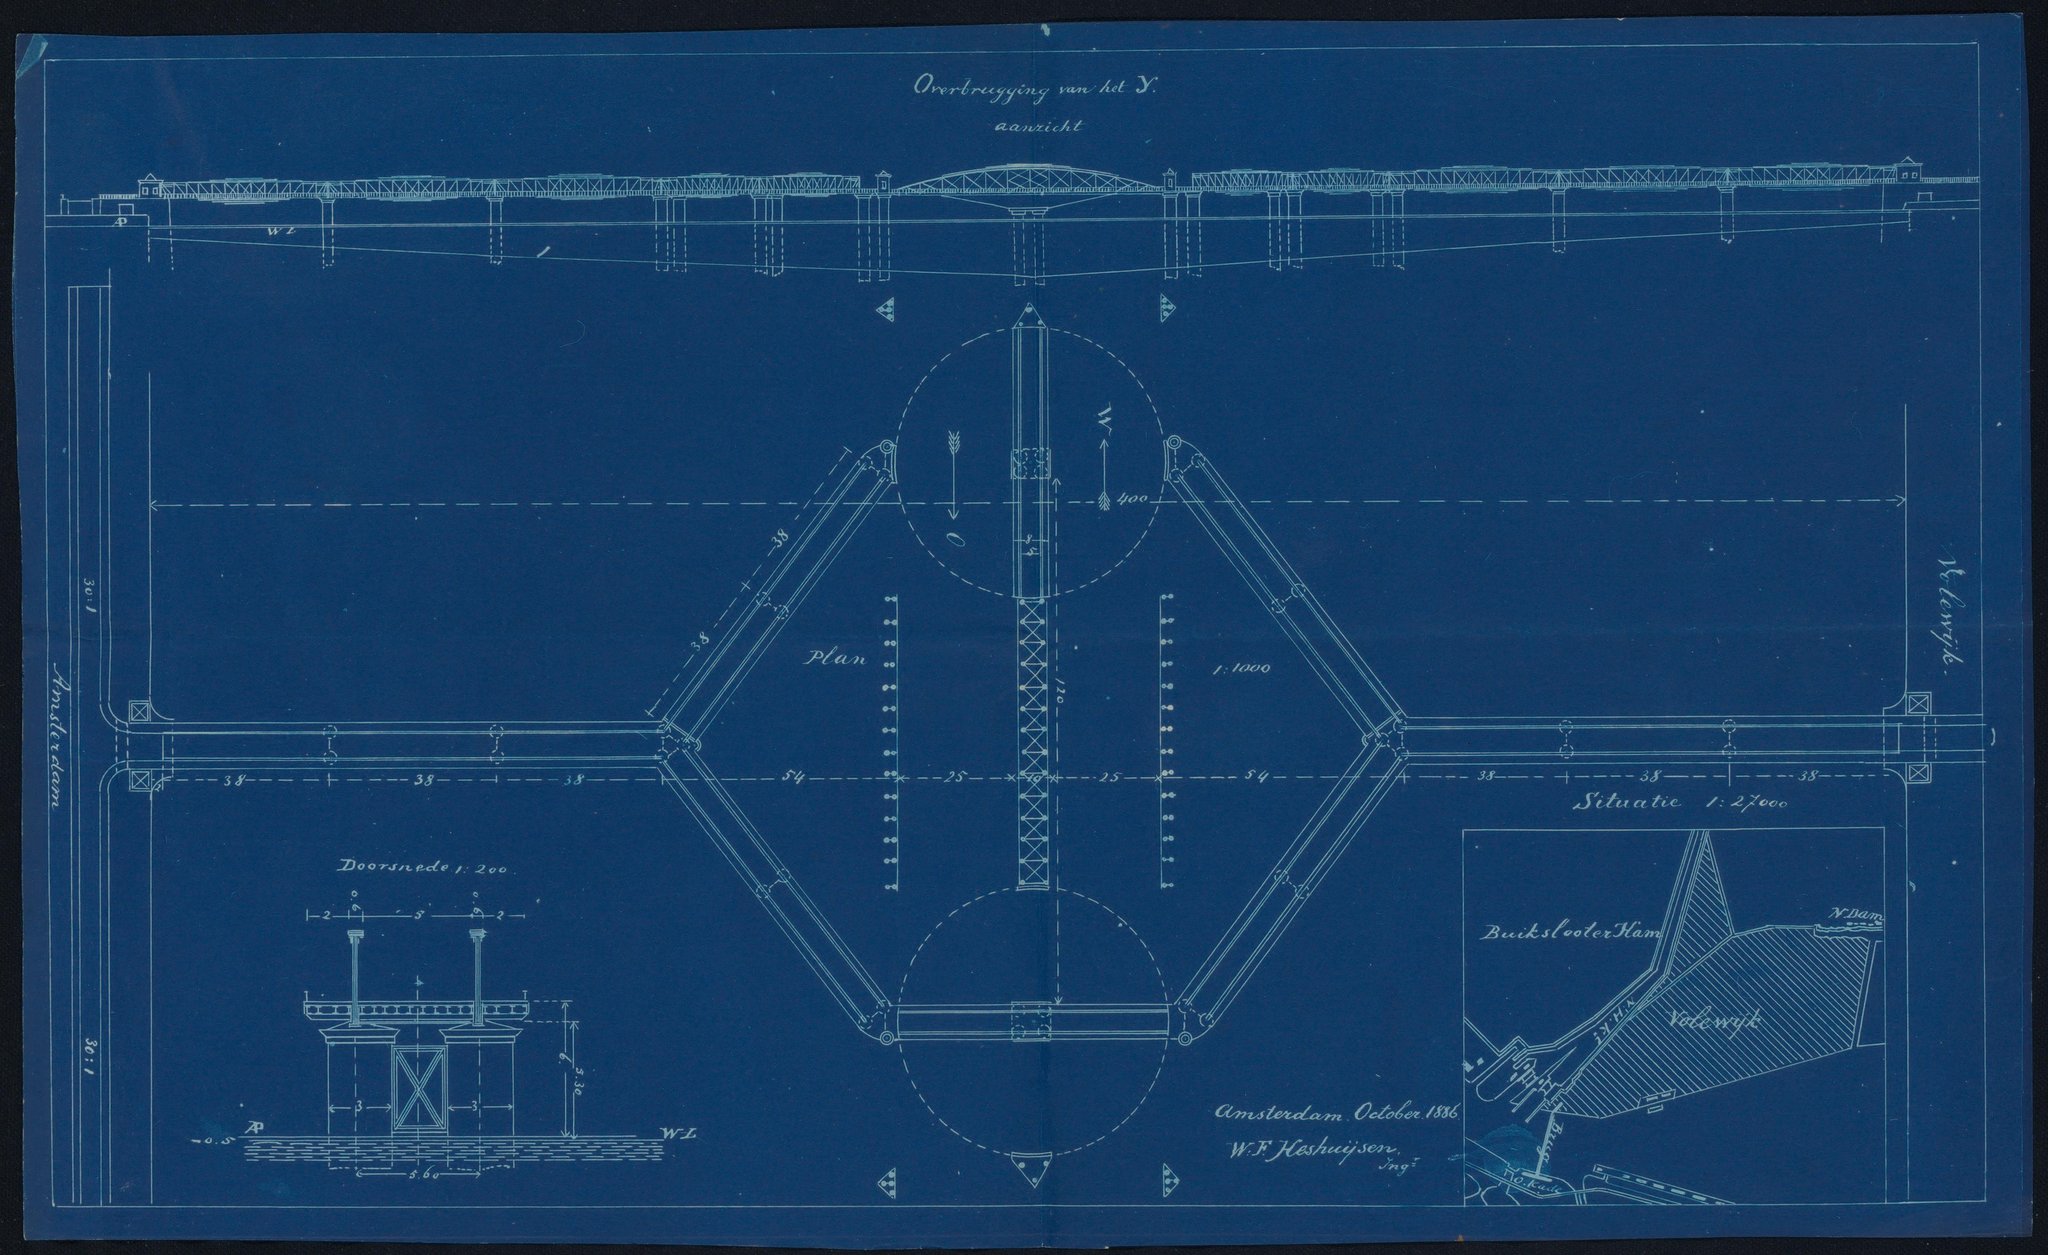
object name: blueprint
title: Blauwdruk met tekening voor de overbrugging van het IJ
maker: heshuijsen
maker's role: engineer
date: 1810-1886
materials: paper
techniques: blueprint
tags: engineering, bridge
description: Onderwerpsrubriek binnen de Atlas Amsterdam: Tunnel onder het IJ, Bruggen over het IJ.